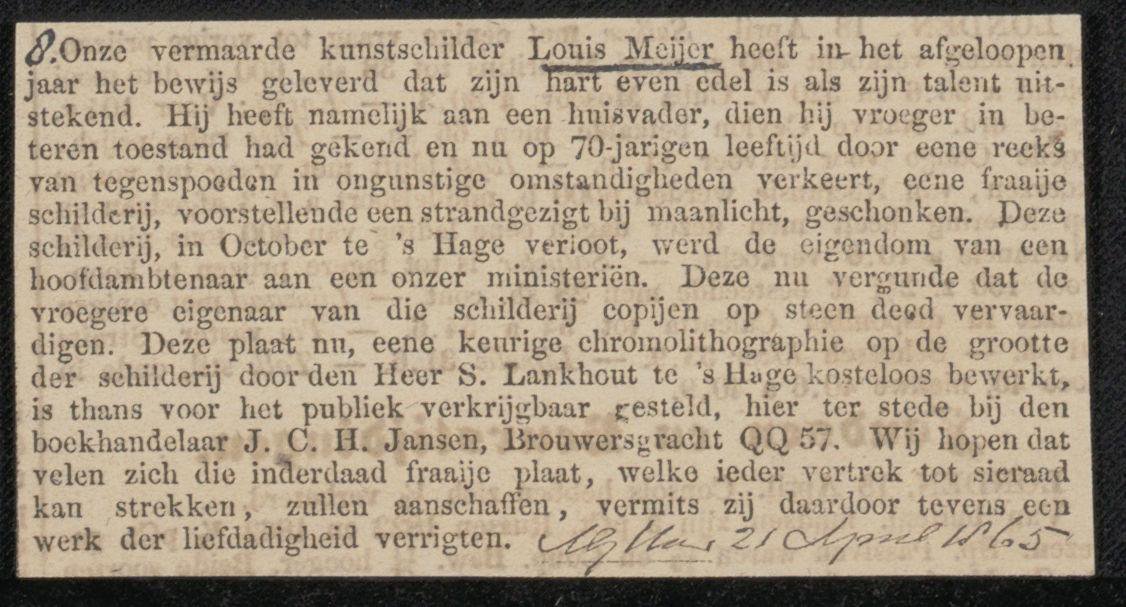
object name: newspaper clipping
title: Krantenknipsel betreffende Louis Meijer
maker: Anonymous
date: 1865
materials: paper, ink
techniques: printing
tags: utrecht, painter, print maker, draughtsman, louis meijer